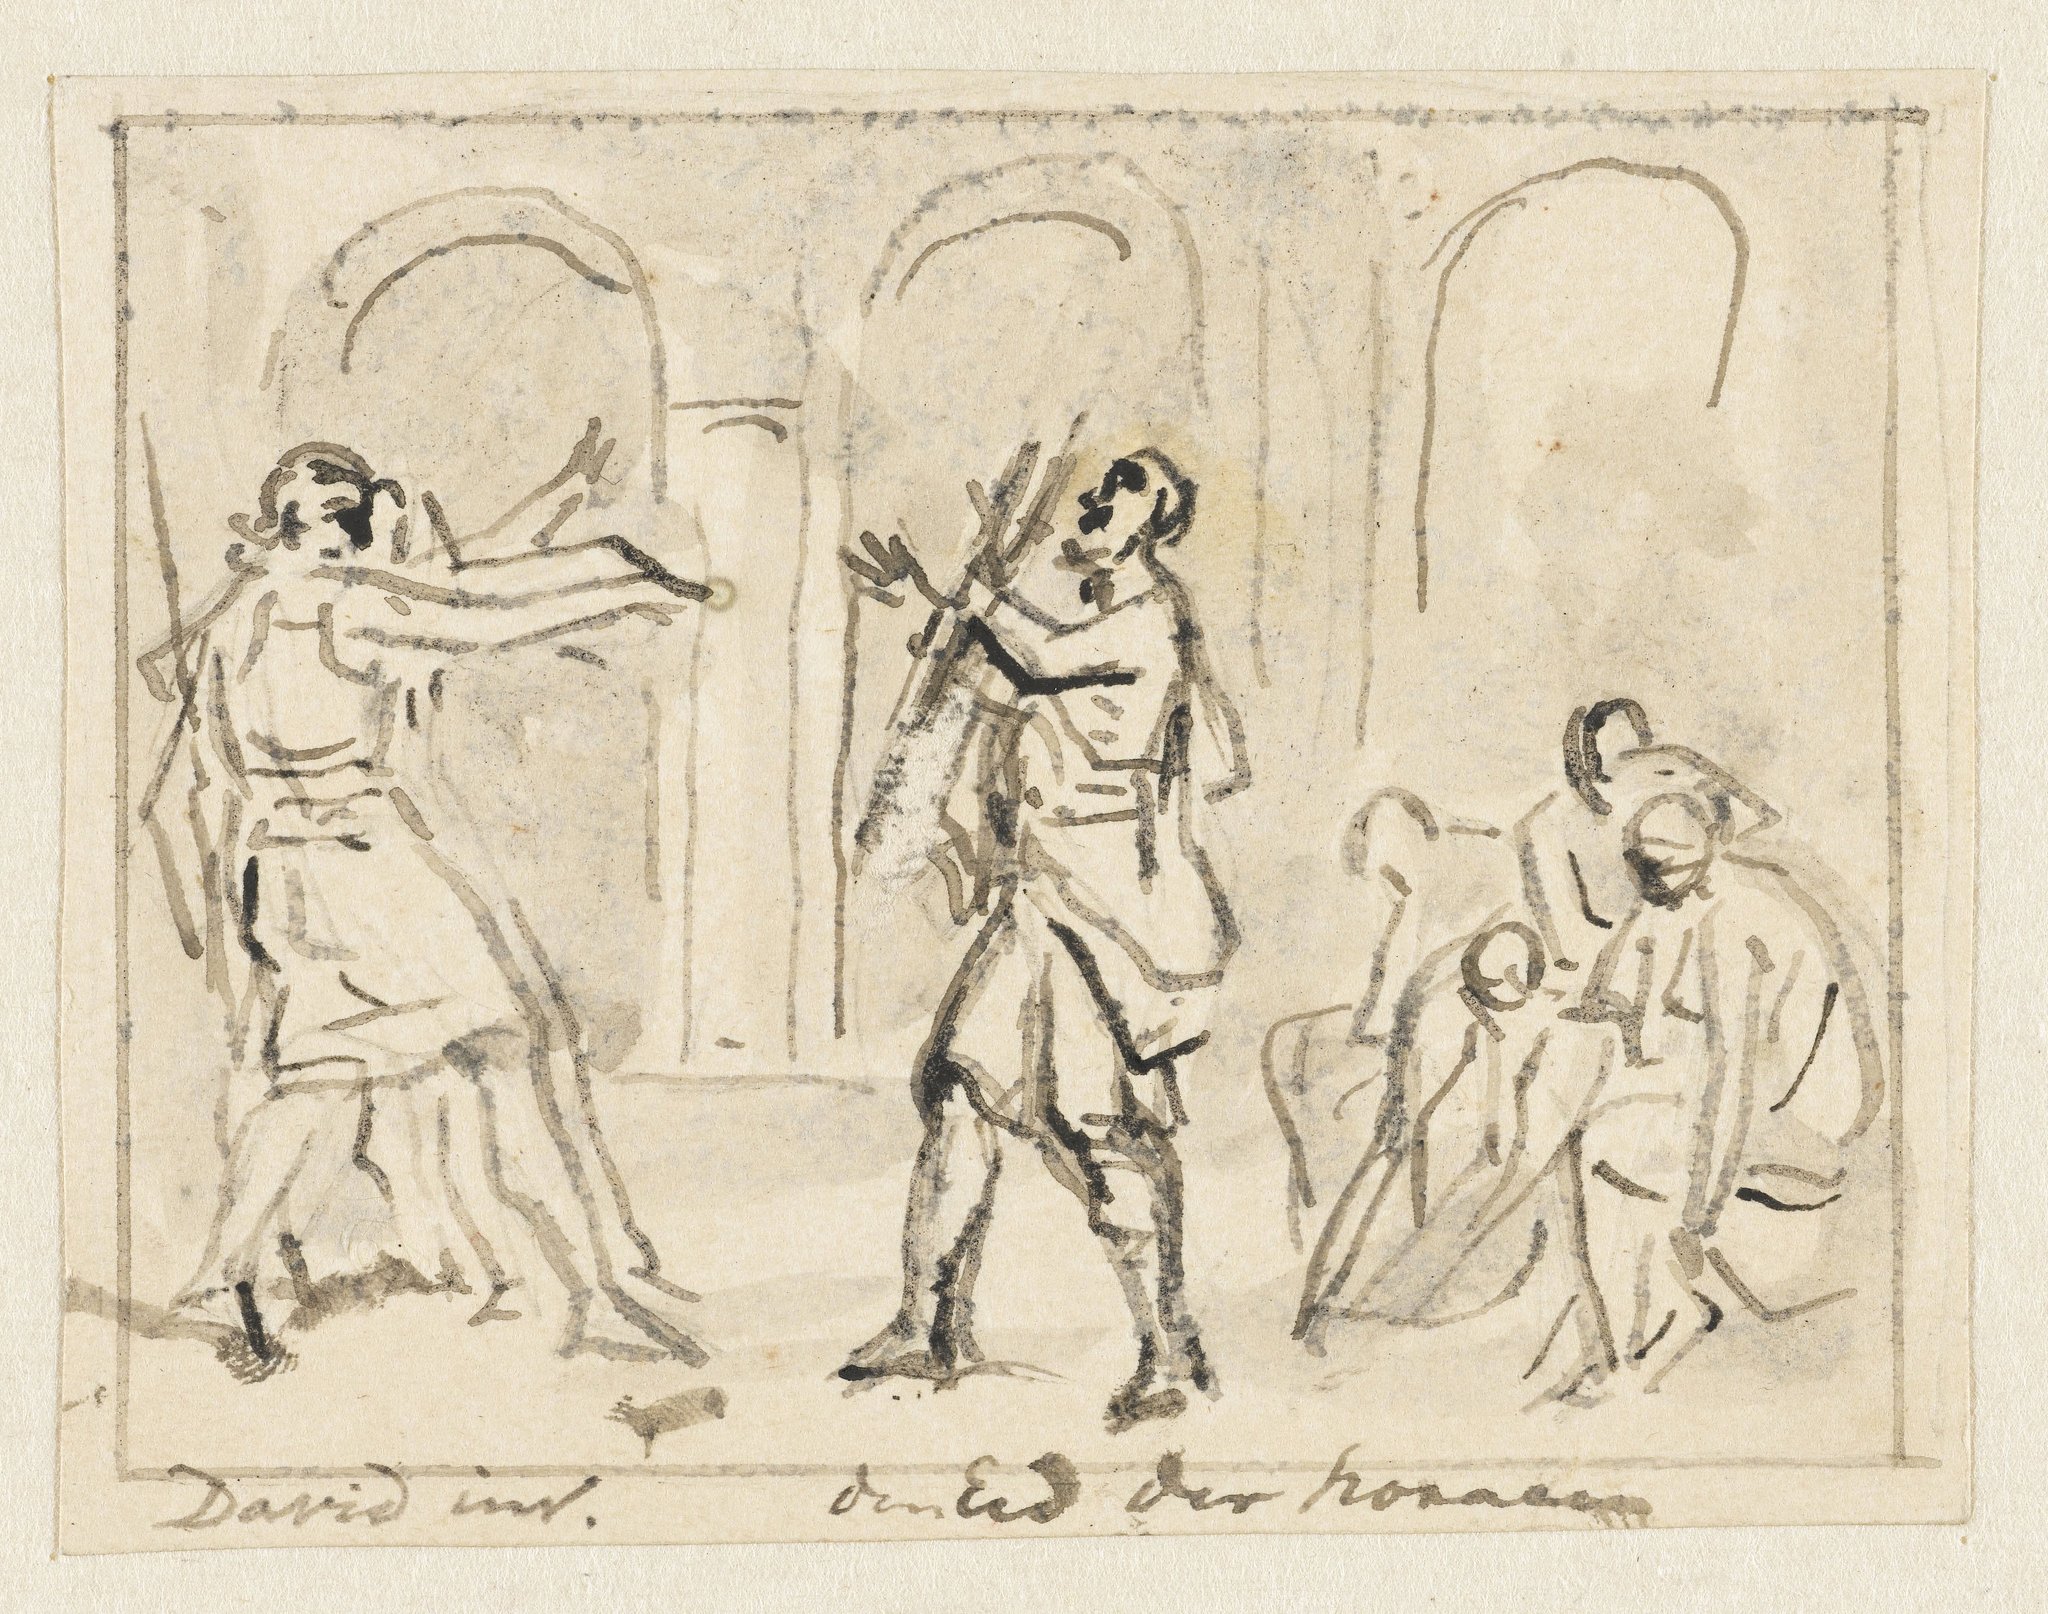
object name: drawing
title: De Eed der Horatii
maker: jurriaan andriessen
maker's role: draughtsman, painter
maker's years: 1742-1819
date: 1752-1819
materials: graphite, ink, paper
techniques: brush, pen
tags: print, e.g.: engraving, etching, lithograph